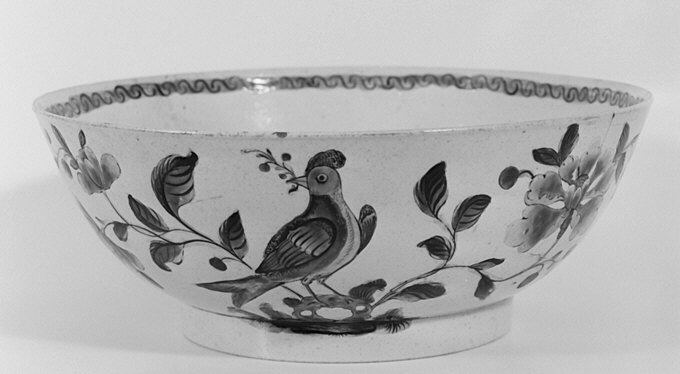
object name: bowl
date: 1760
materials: stoneware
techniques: salt glaze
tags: birds